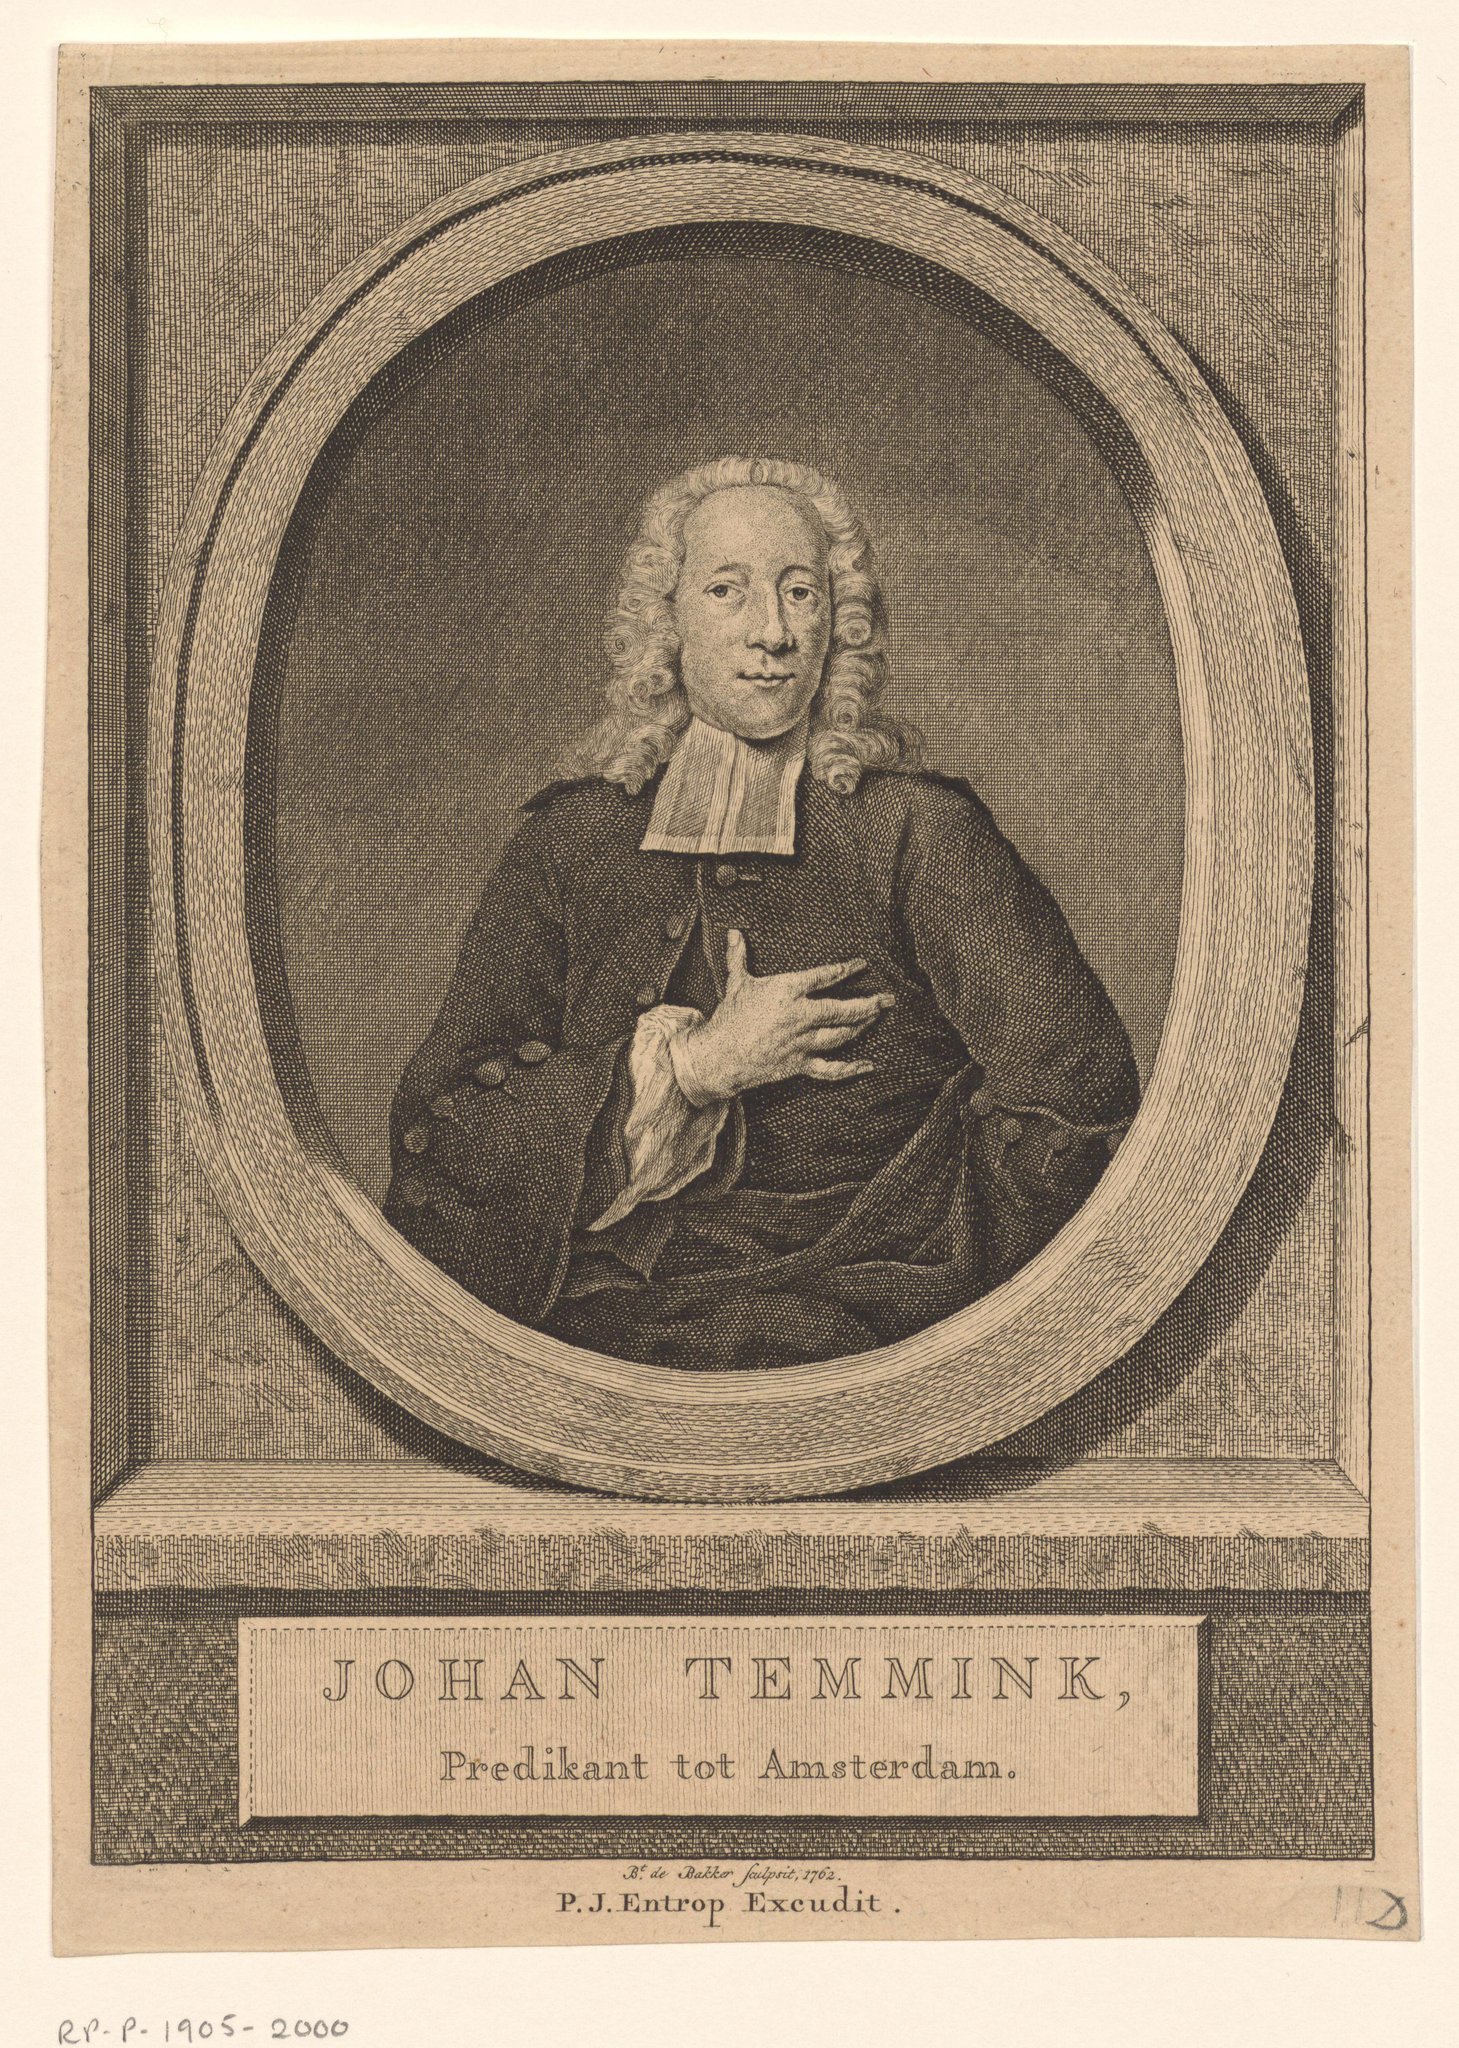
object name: print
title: Portret van Johan Temmink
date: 1762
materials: paper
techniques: engraving, etching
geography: amsterdam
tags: historical persons, functionaries and dignitaries ~ episcopal protestant churches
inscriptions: collector's mark: Lugt 2228